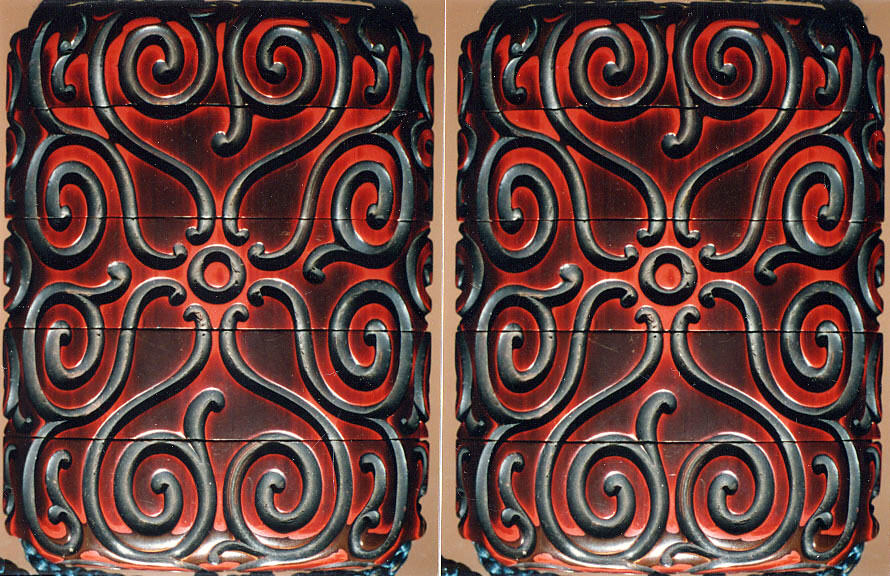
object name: inrō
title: Case (Inrō) with Design of Pommel-scroll (guri)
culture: japanese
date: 1701-1900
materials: lacquer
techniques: fundame